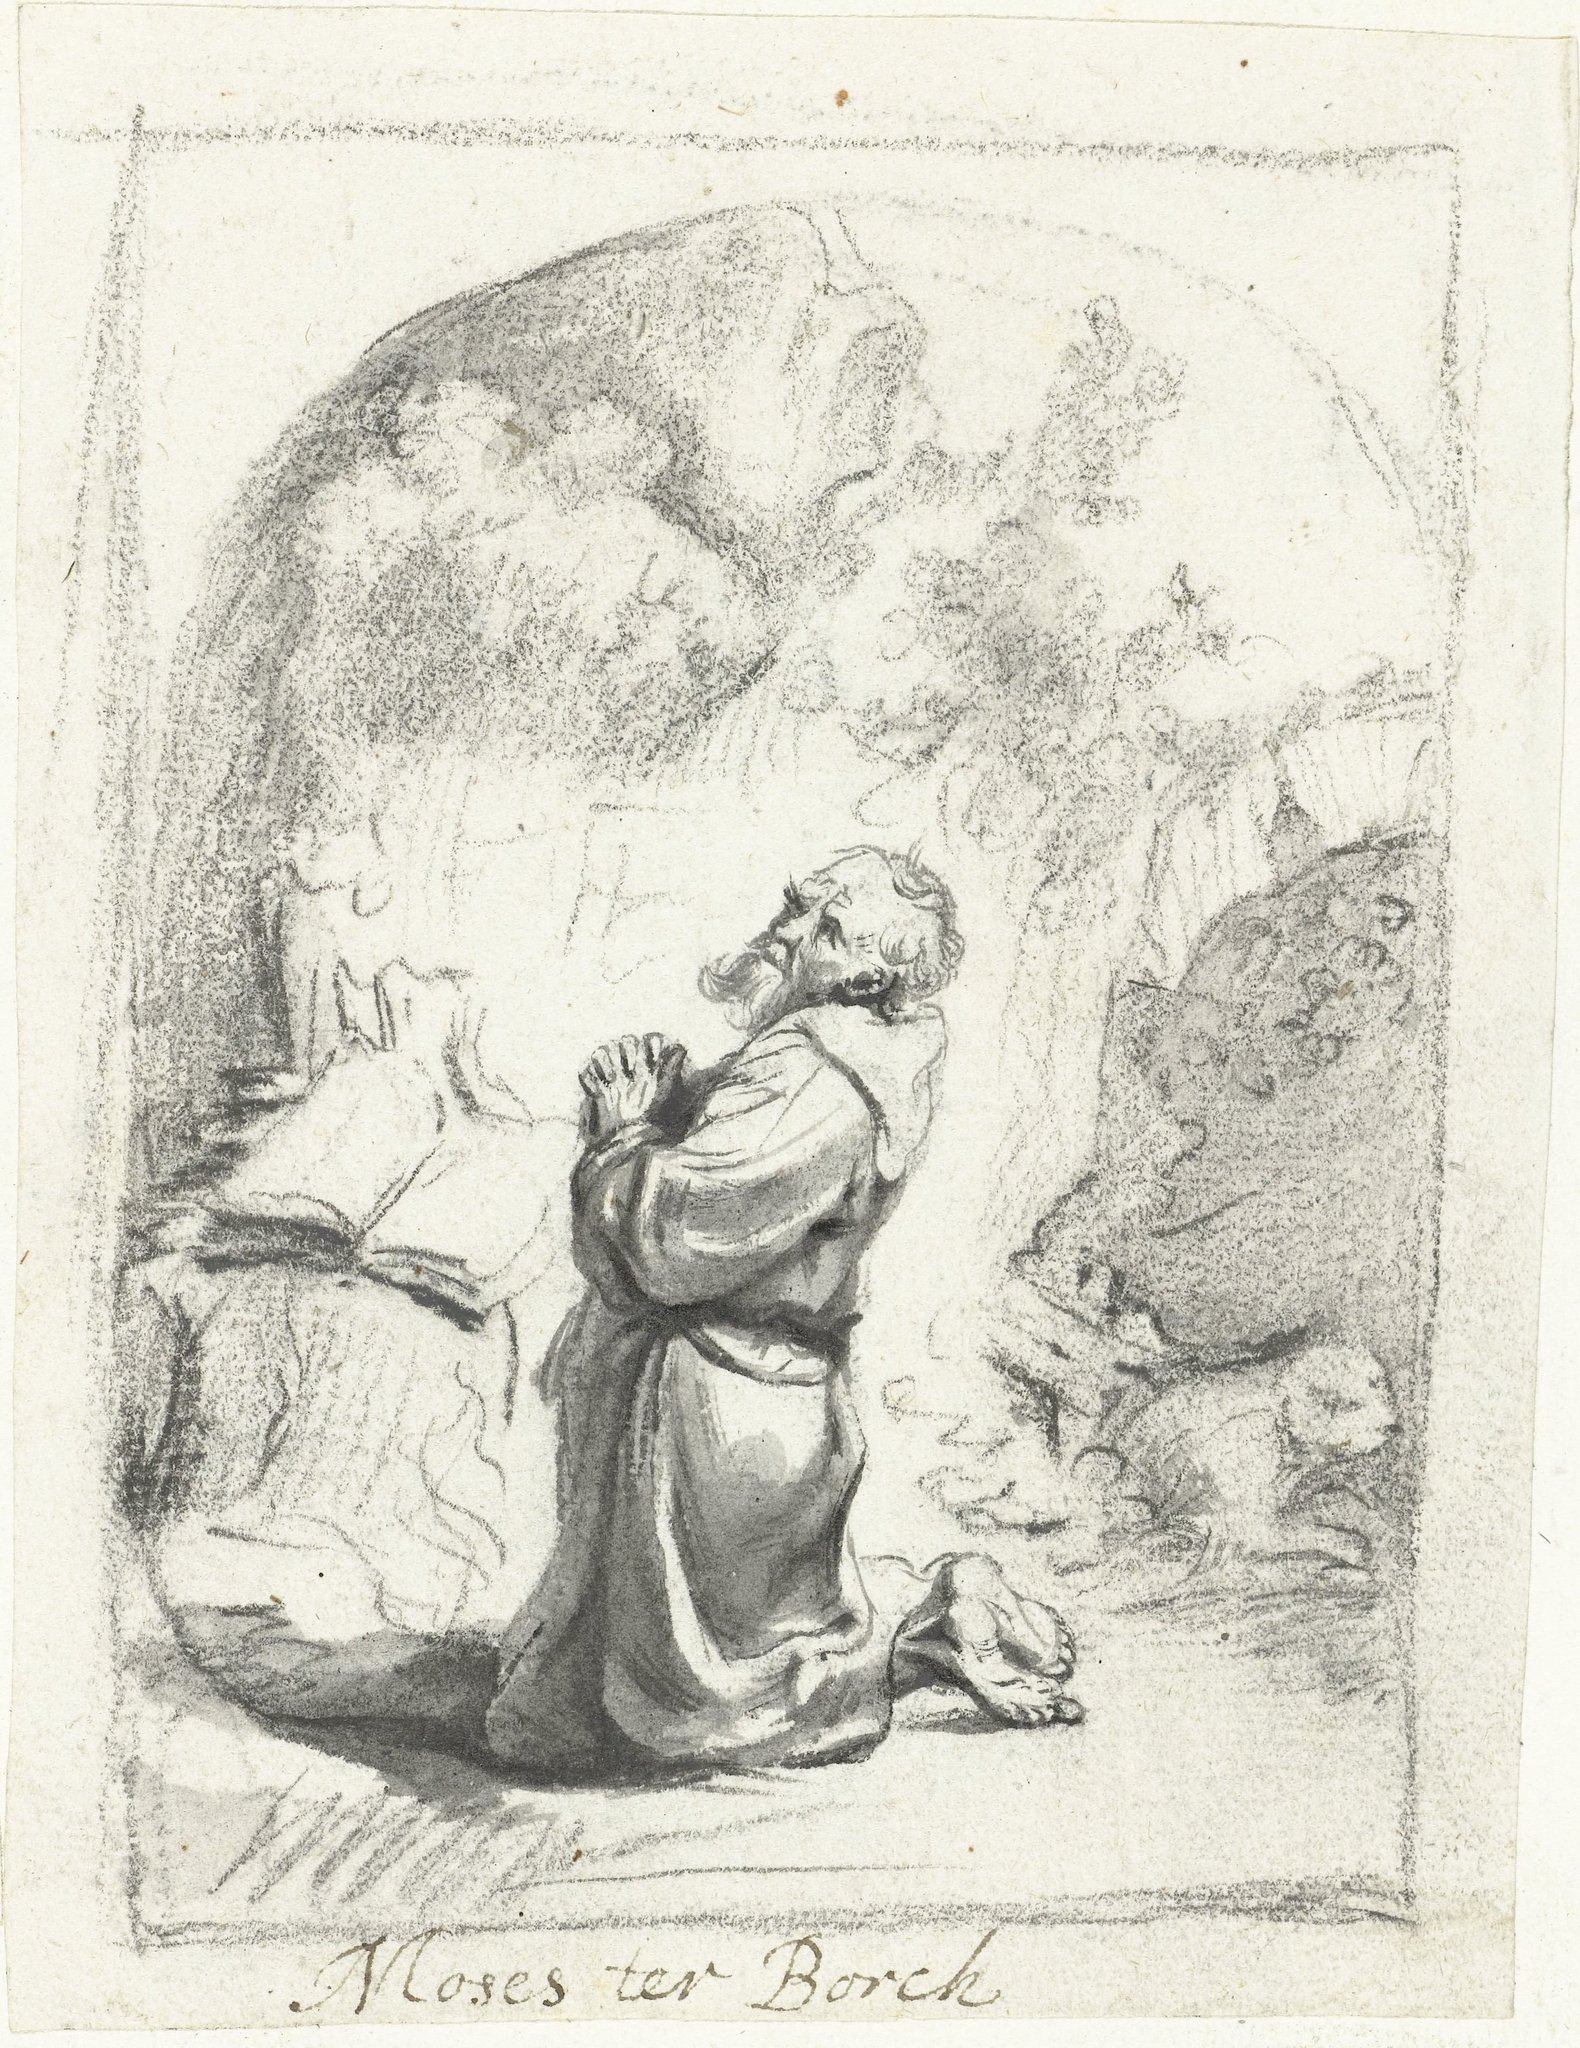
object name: drawing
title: Heilige Hieronymus in gebed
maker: moses ter borch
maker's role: draughtsman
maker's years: 1645-1667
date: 1659-1661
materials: chalk, ink, paper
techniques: brush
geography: zwolle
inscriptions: annotation: ‘Moses ter Borch’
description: Kopie naar een prent van Rembrandt (B. 101). De tekening is in het Plakboek op een bladzijde geplakt samen met twee andere tekeningen.